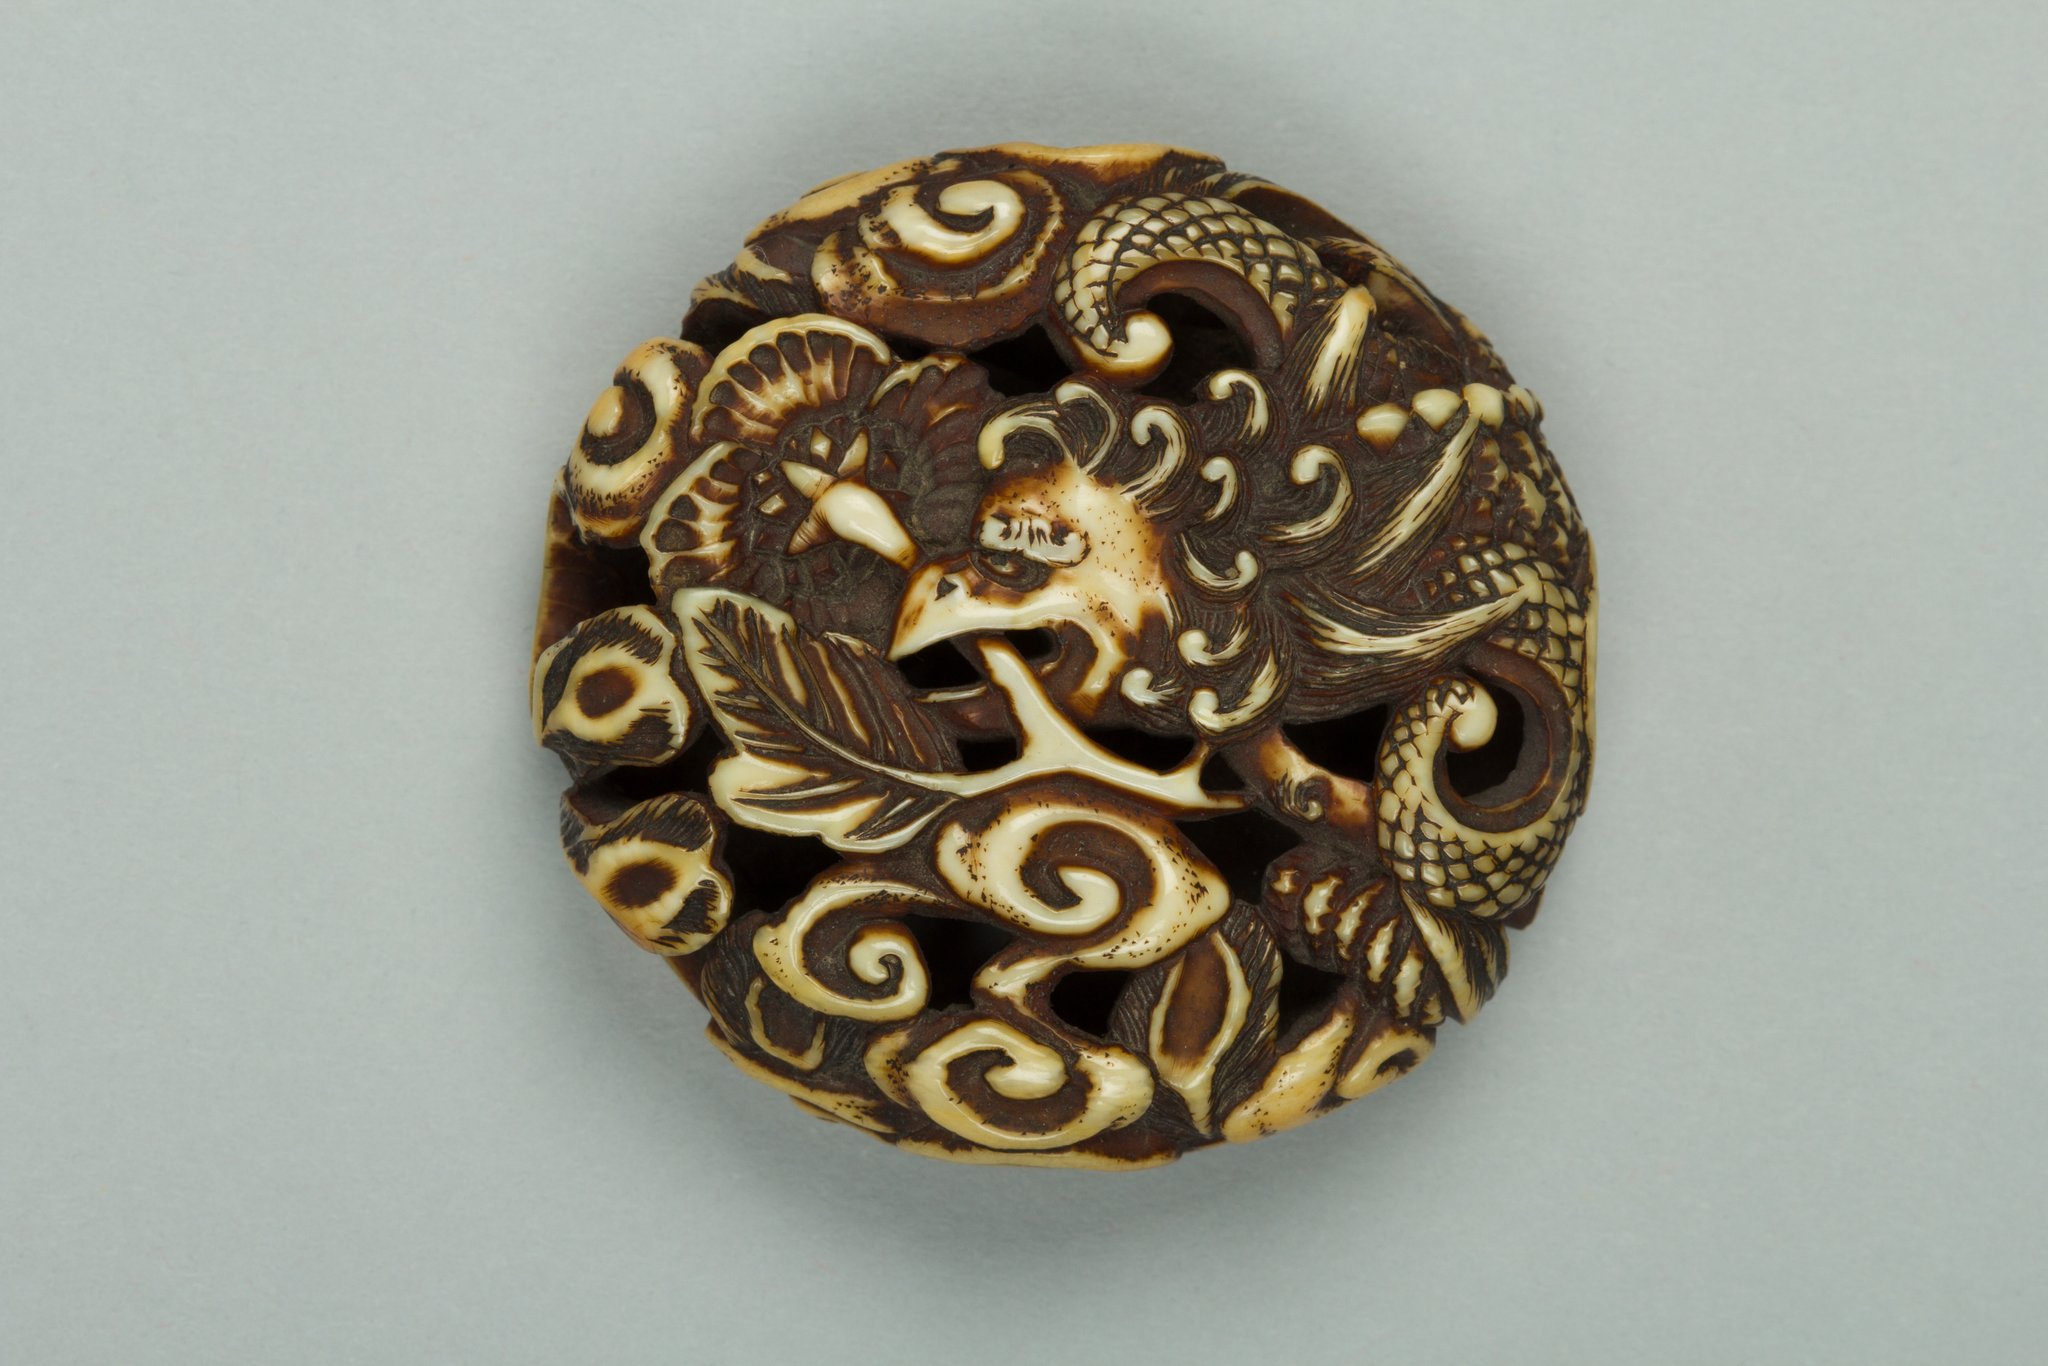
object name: netsuke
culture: japanese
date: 1801-1900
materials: ivory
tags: birds